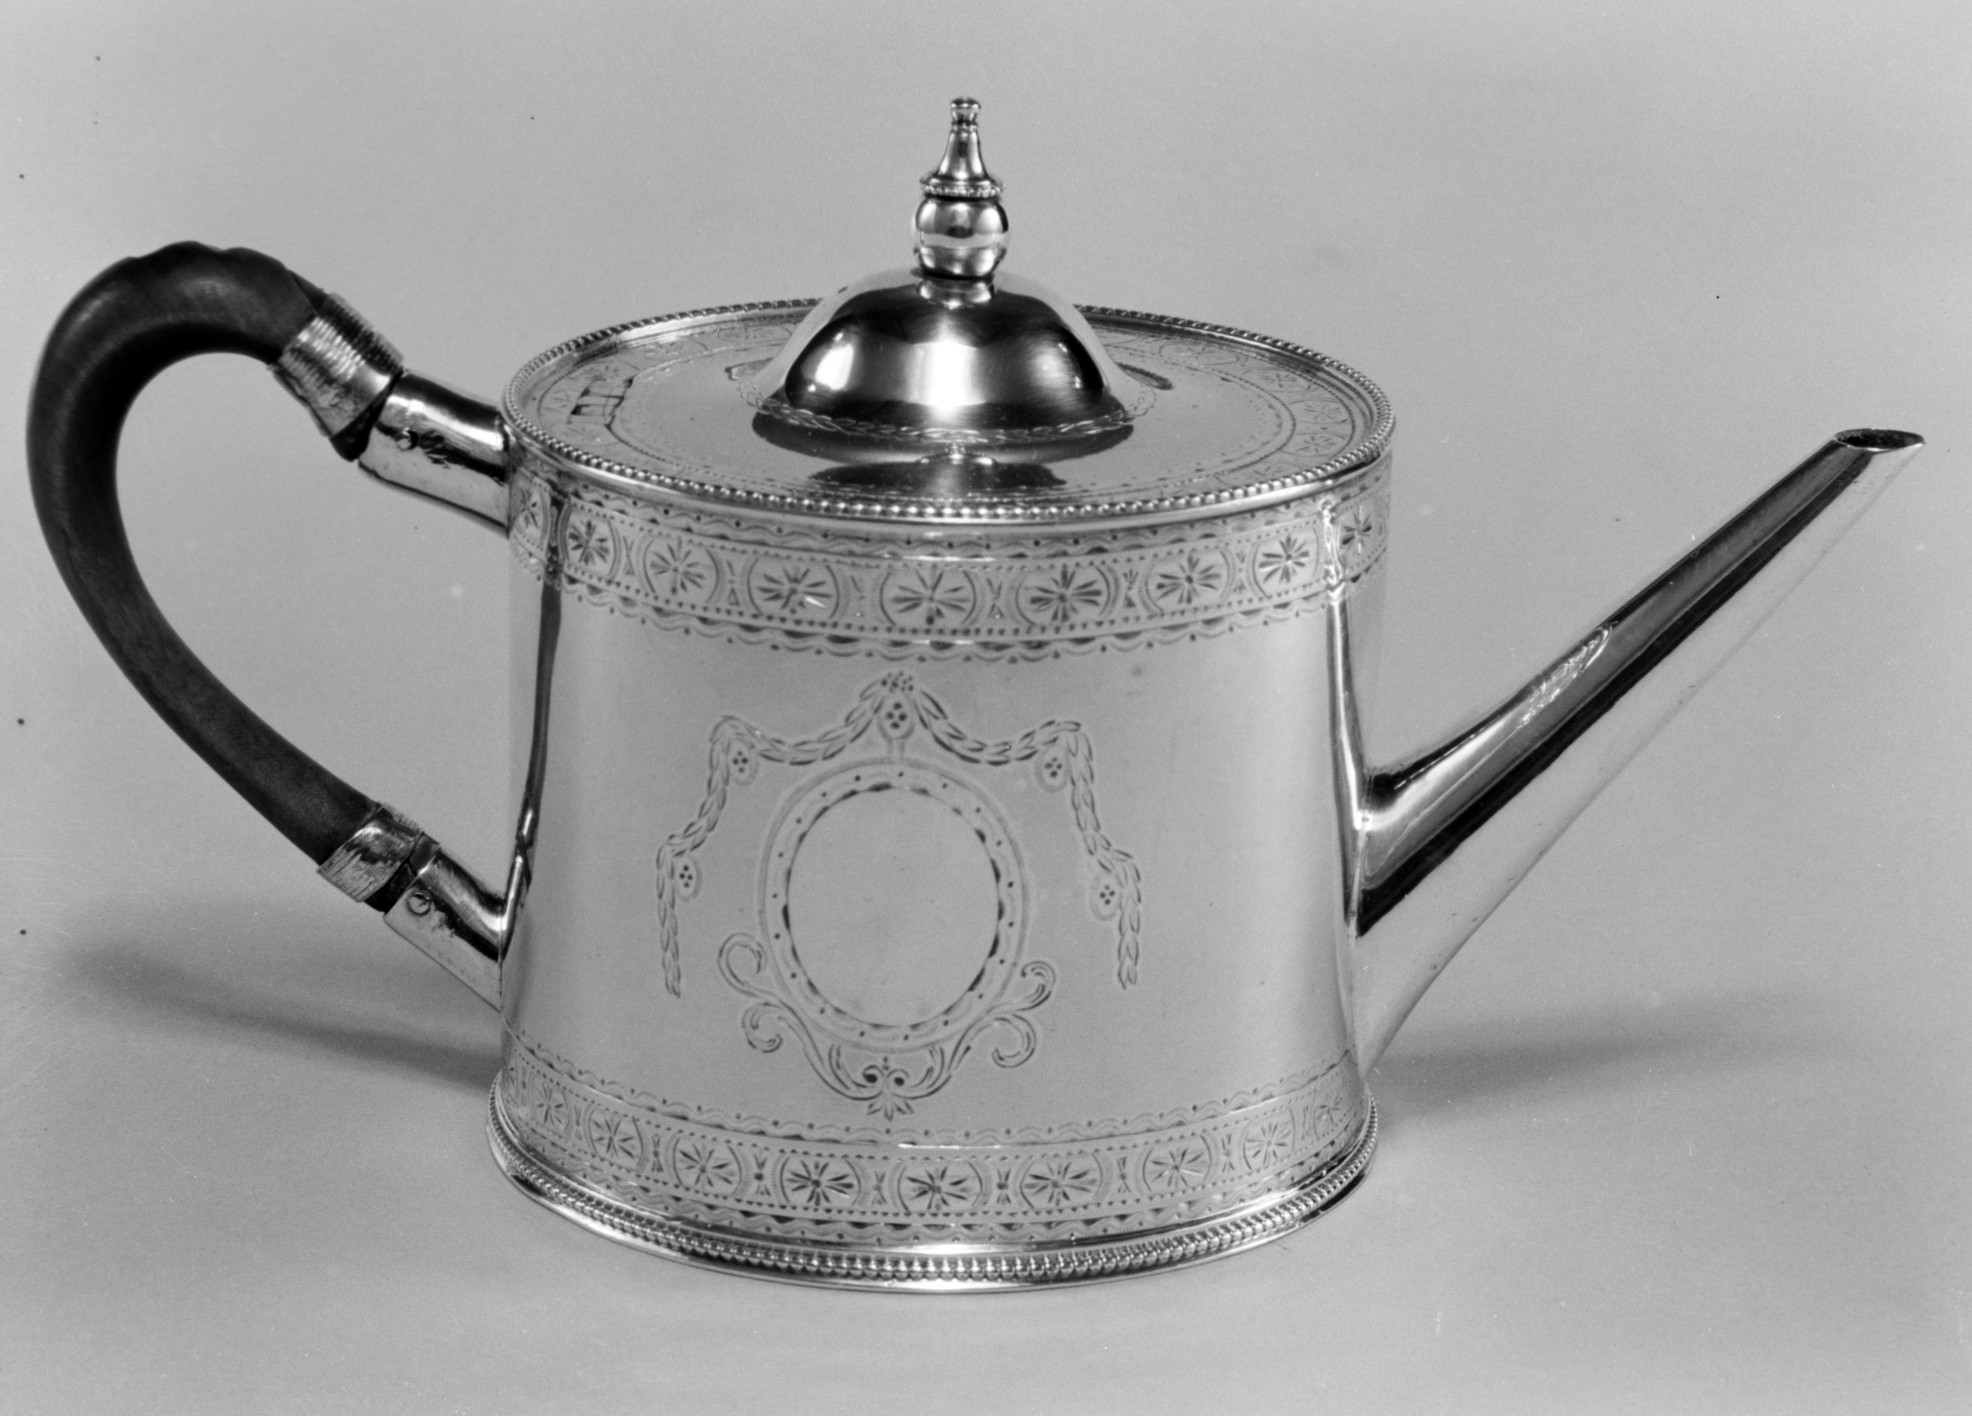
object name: teapot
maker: francis stamp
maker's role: maker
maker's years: 1780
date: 1779-1780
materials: silver